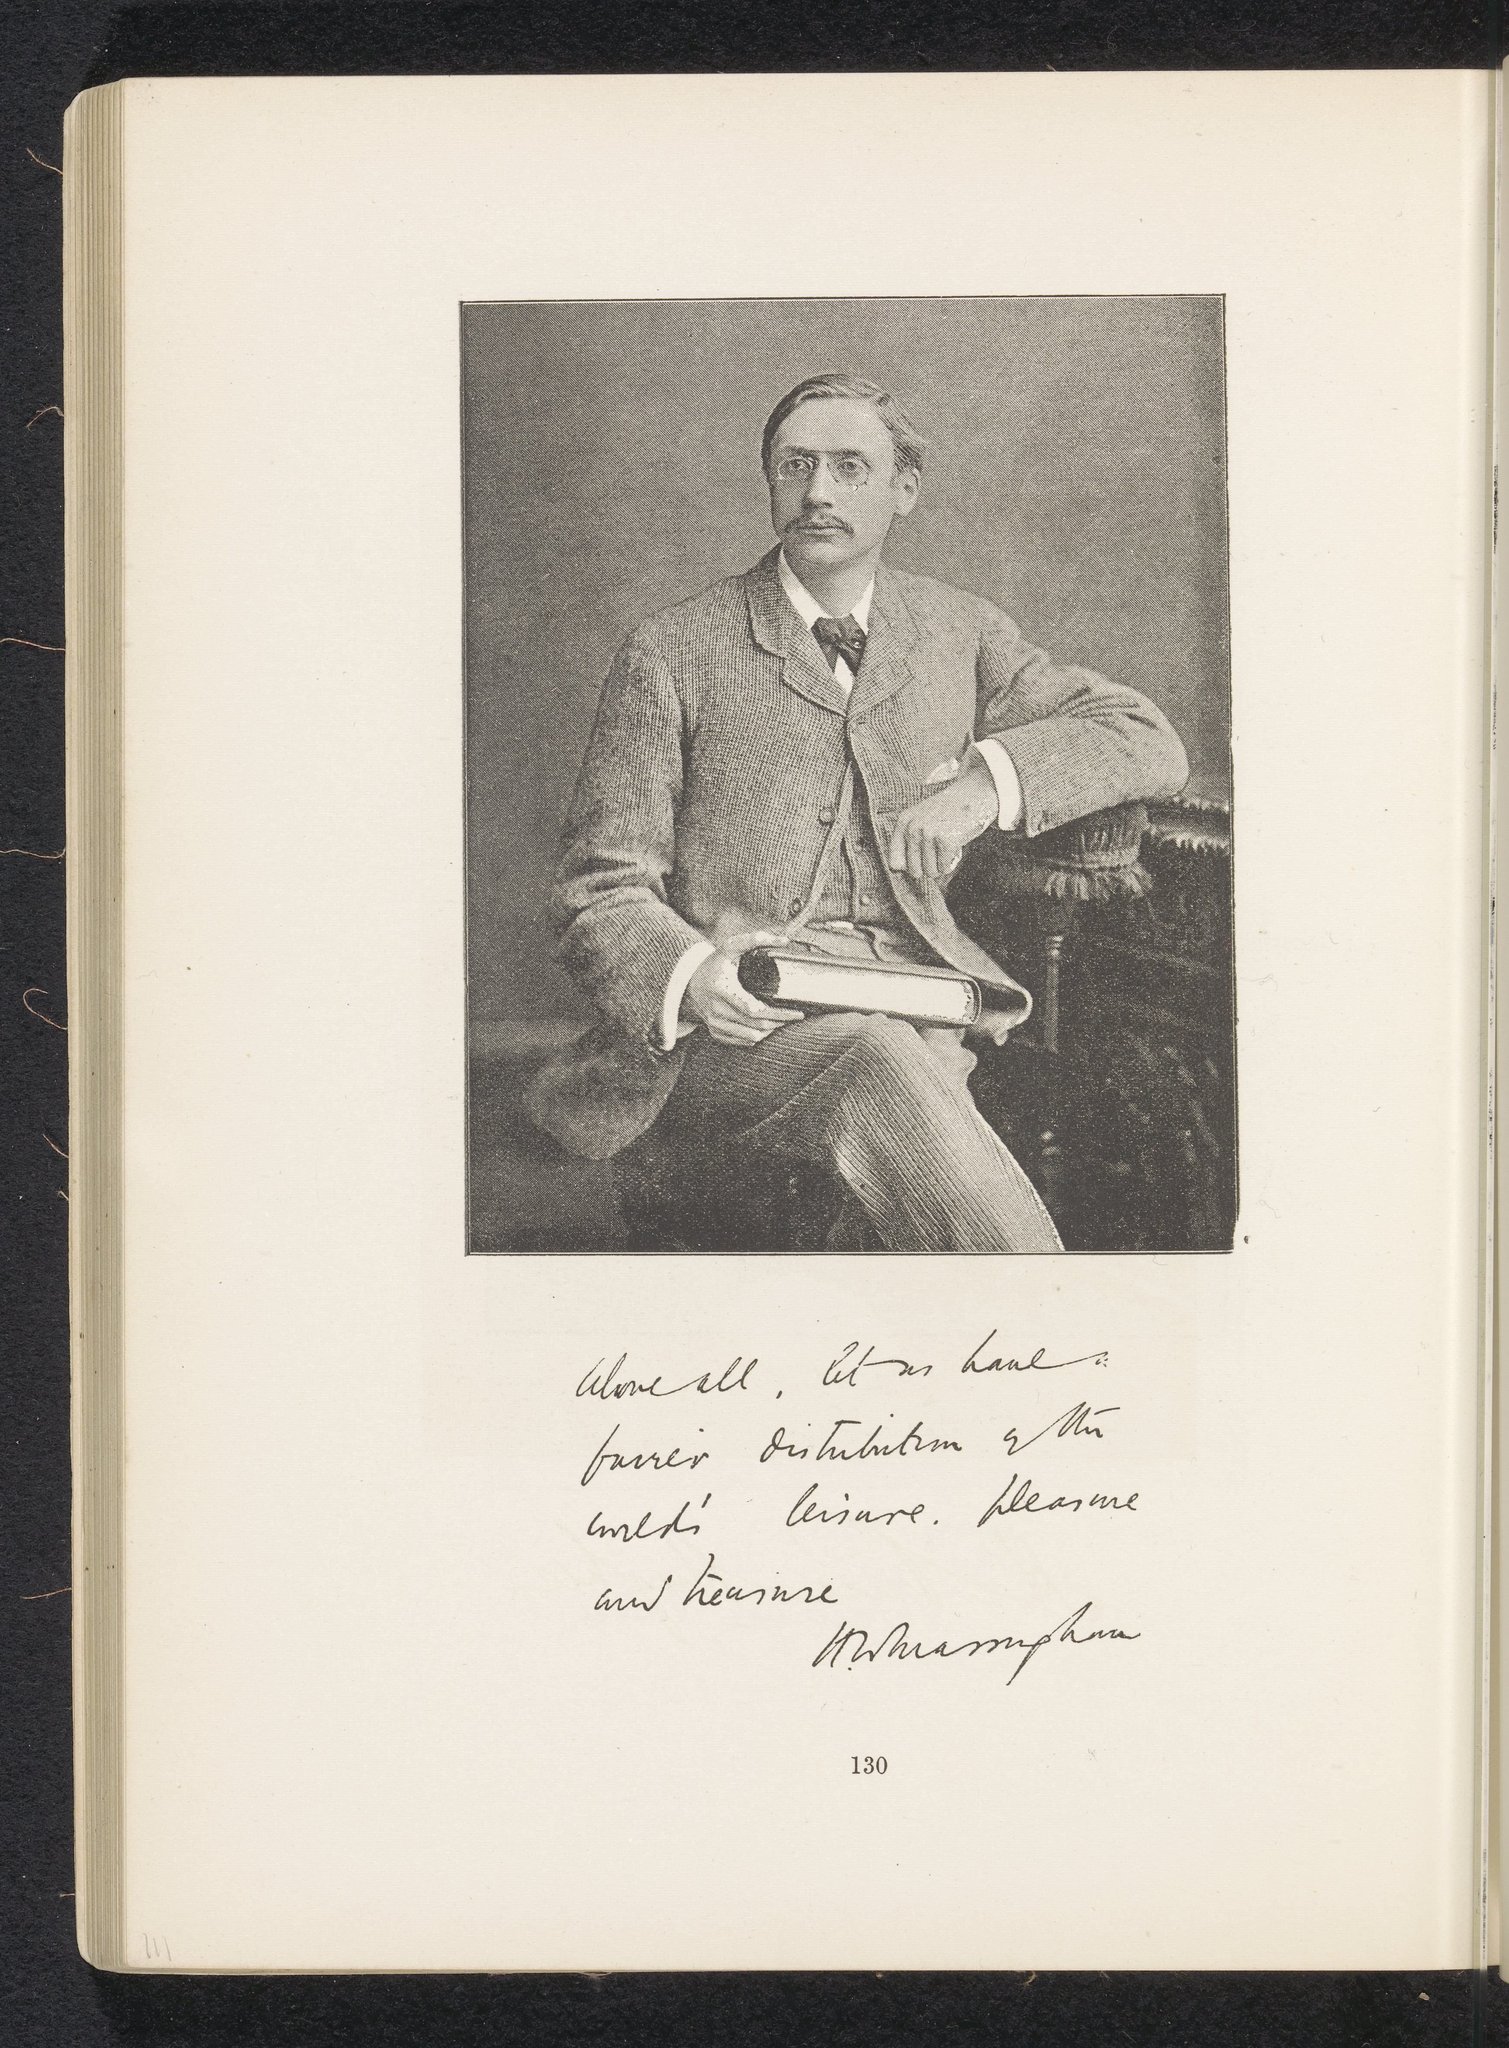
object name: photomechanical print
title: Portret van Henry William Massingham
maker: Anonymous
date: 1881-1891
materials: paper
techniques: autotype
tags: portrait of a writer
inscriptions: inscription